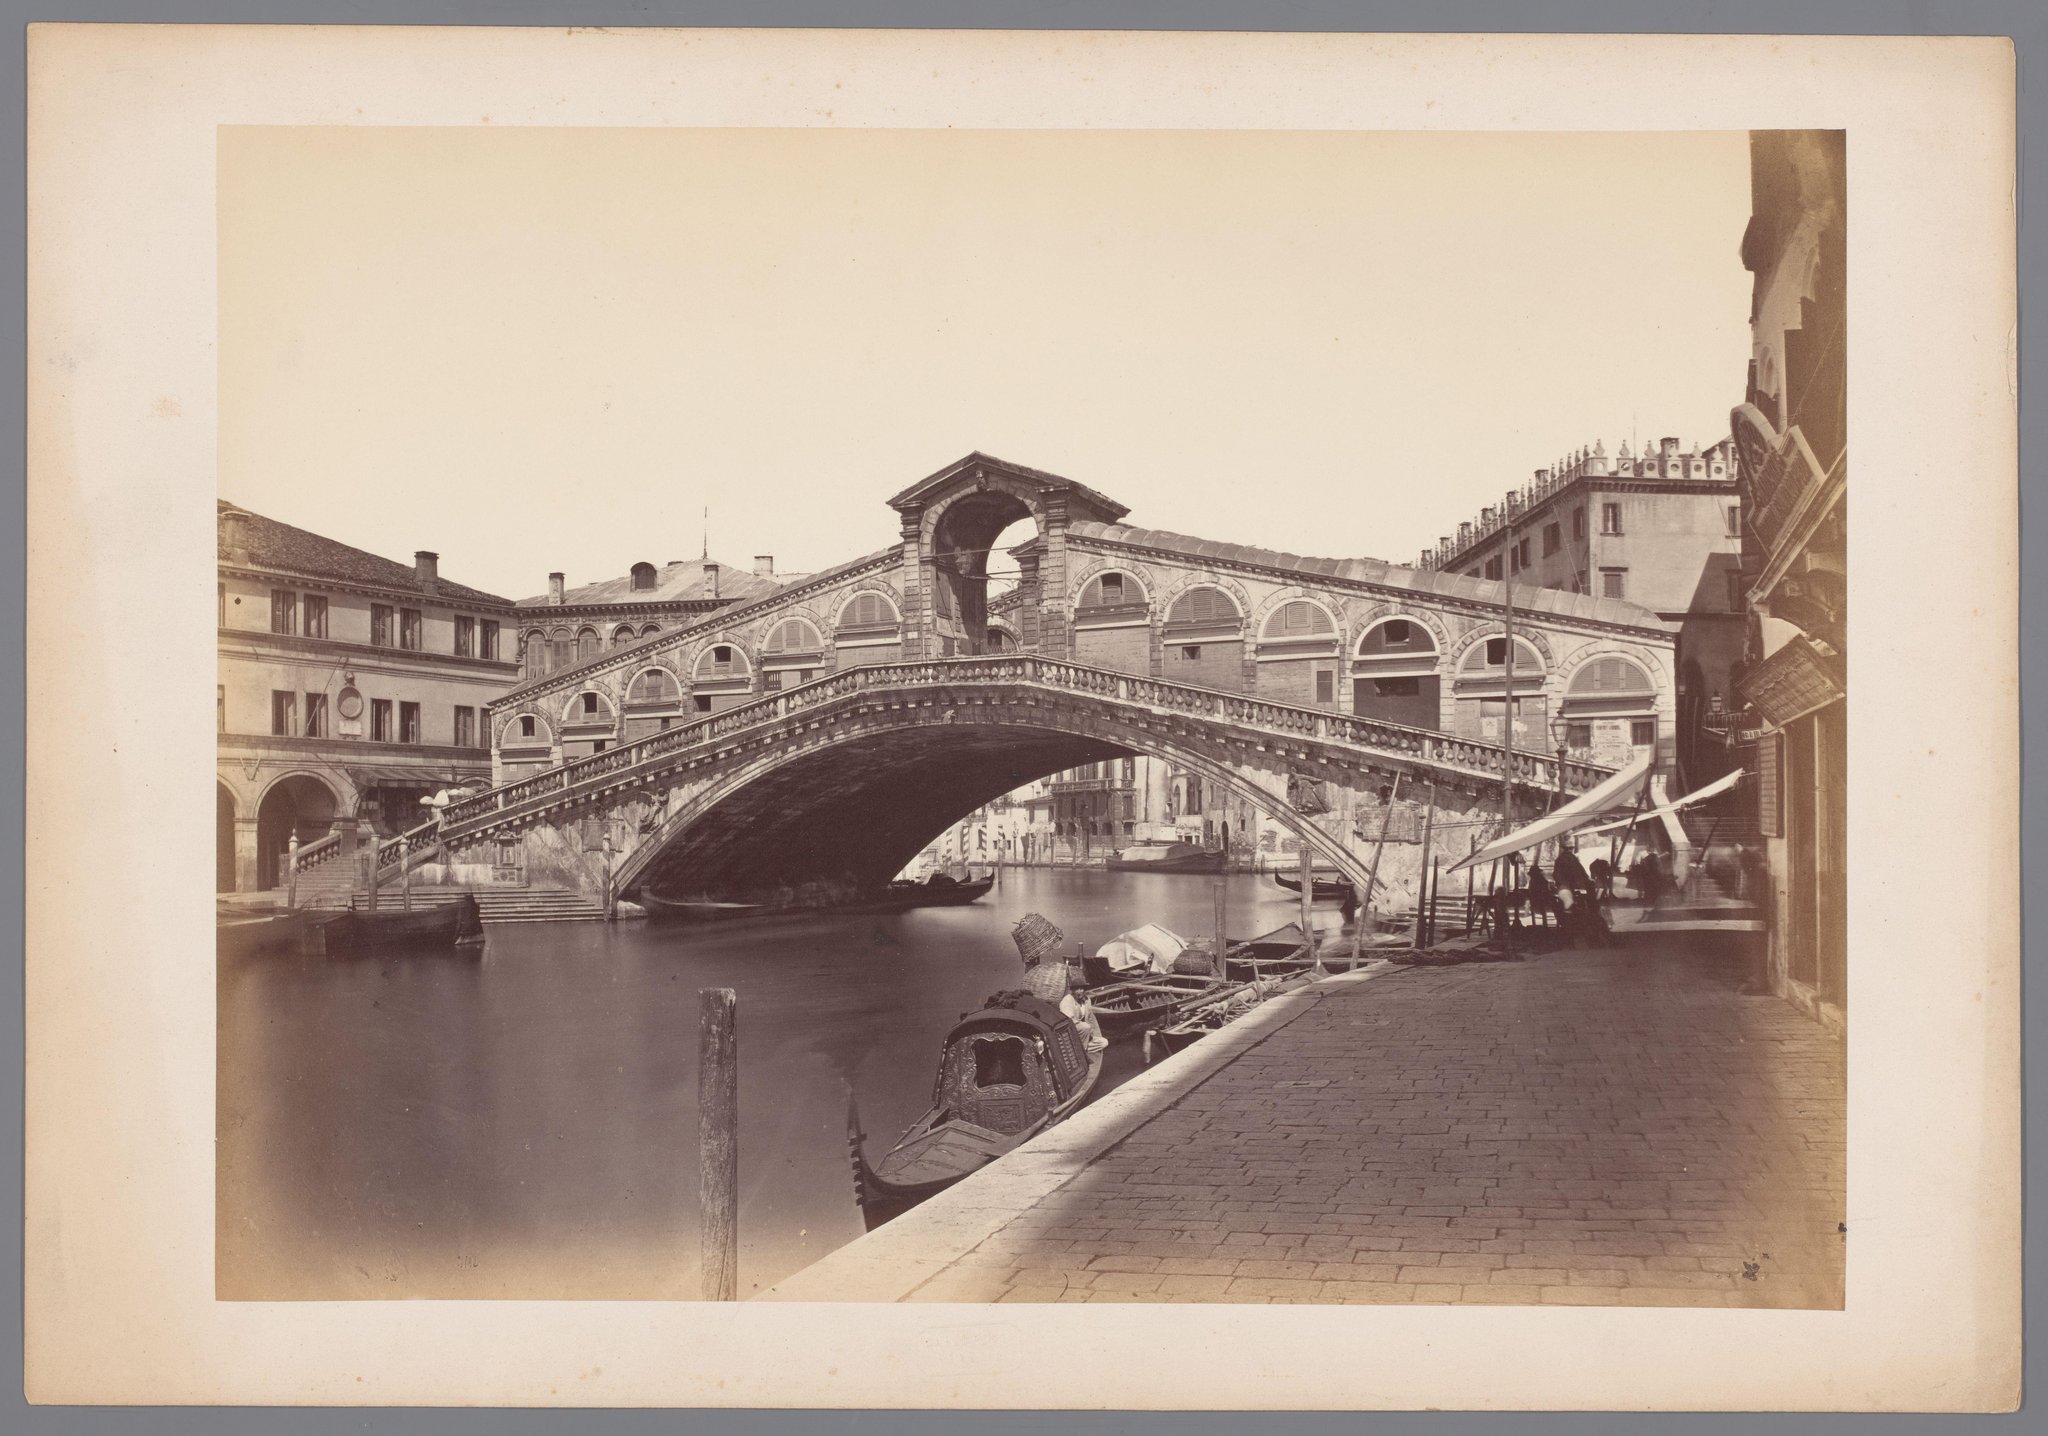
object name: photograph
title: Rialtobrug over het Canal Grande te Venetië, Italië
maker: carlo ponti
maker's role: fotograaf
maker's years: 1820-1893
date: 1852-1893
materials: cardboard, paper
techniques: albumen print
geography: venice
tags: bridge in city across river, canal, etc., quay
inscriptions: inscription: ‘En 1180 les deux bords du Grand Canal furent/ unis moyennant un pont de bateaux, en 1264 on bat-/ tit le premier pont en bois. (...)’, number: ‘N. 199’